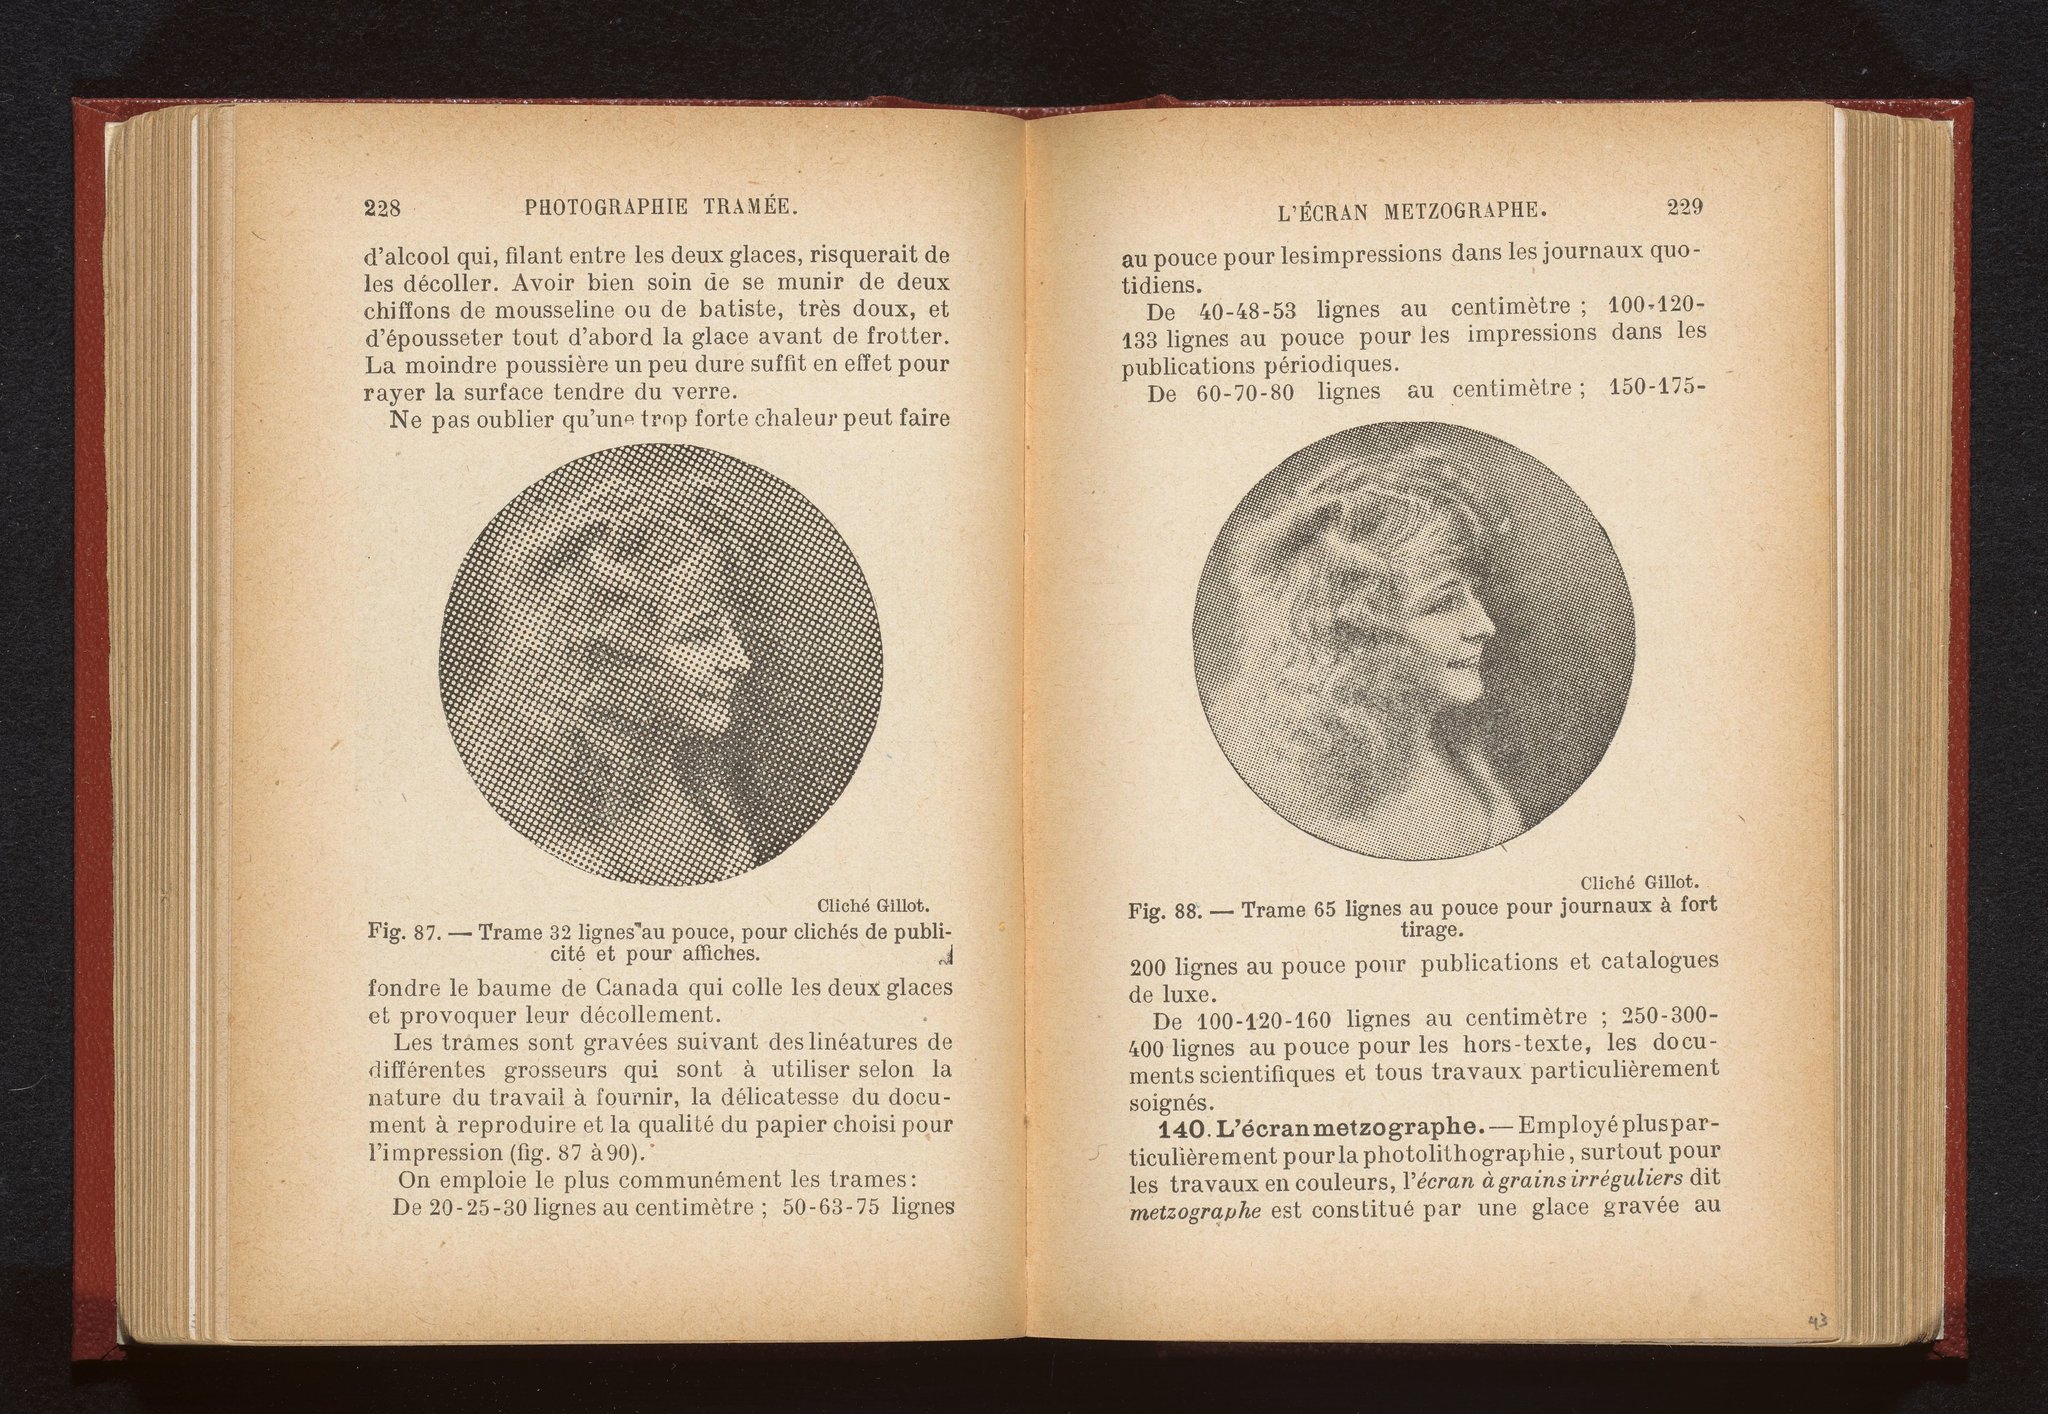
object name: page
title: Portret van een onbekende vrouw in een grof raster van 65 lijnen per inch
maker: Anonymous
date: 1922-1932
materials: paper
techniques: autotype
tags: adult woman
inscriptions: number: ‘Fig. 88.’